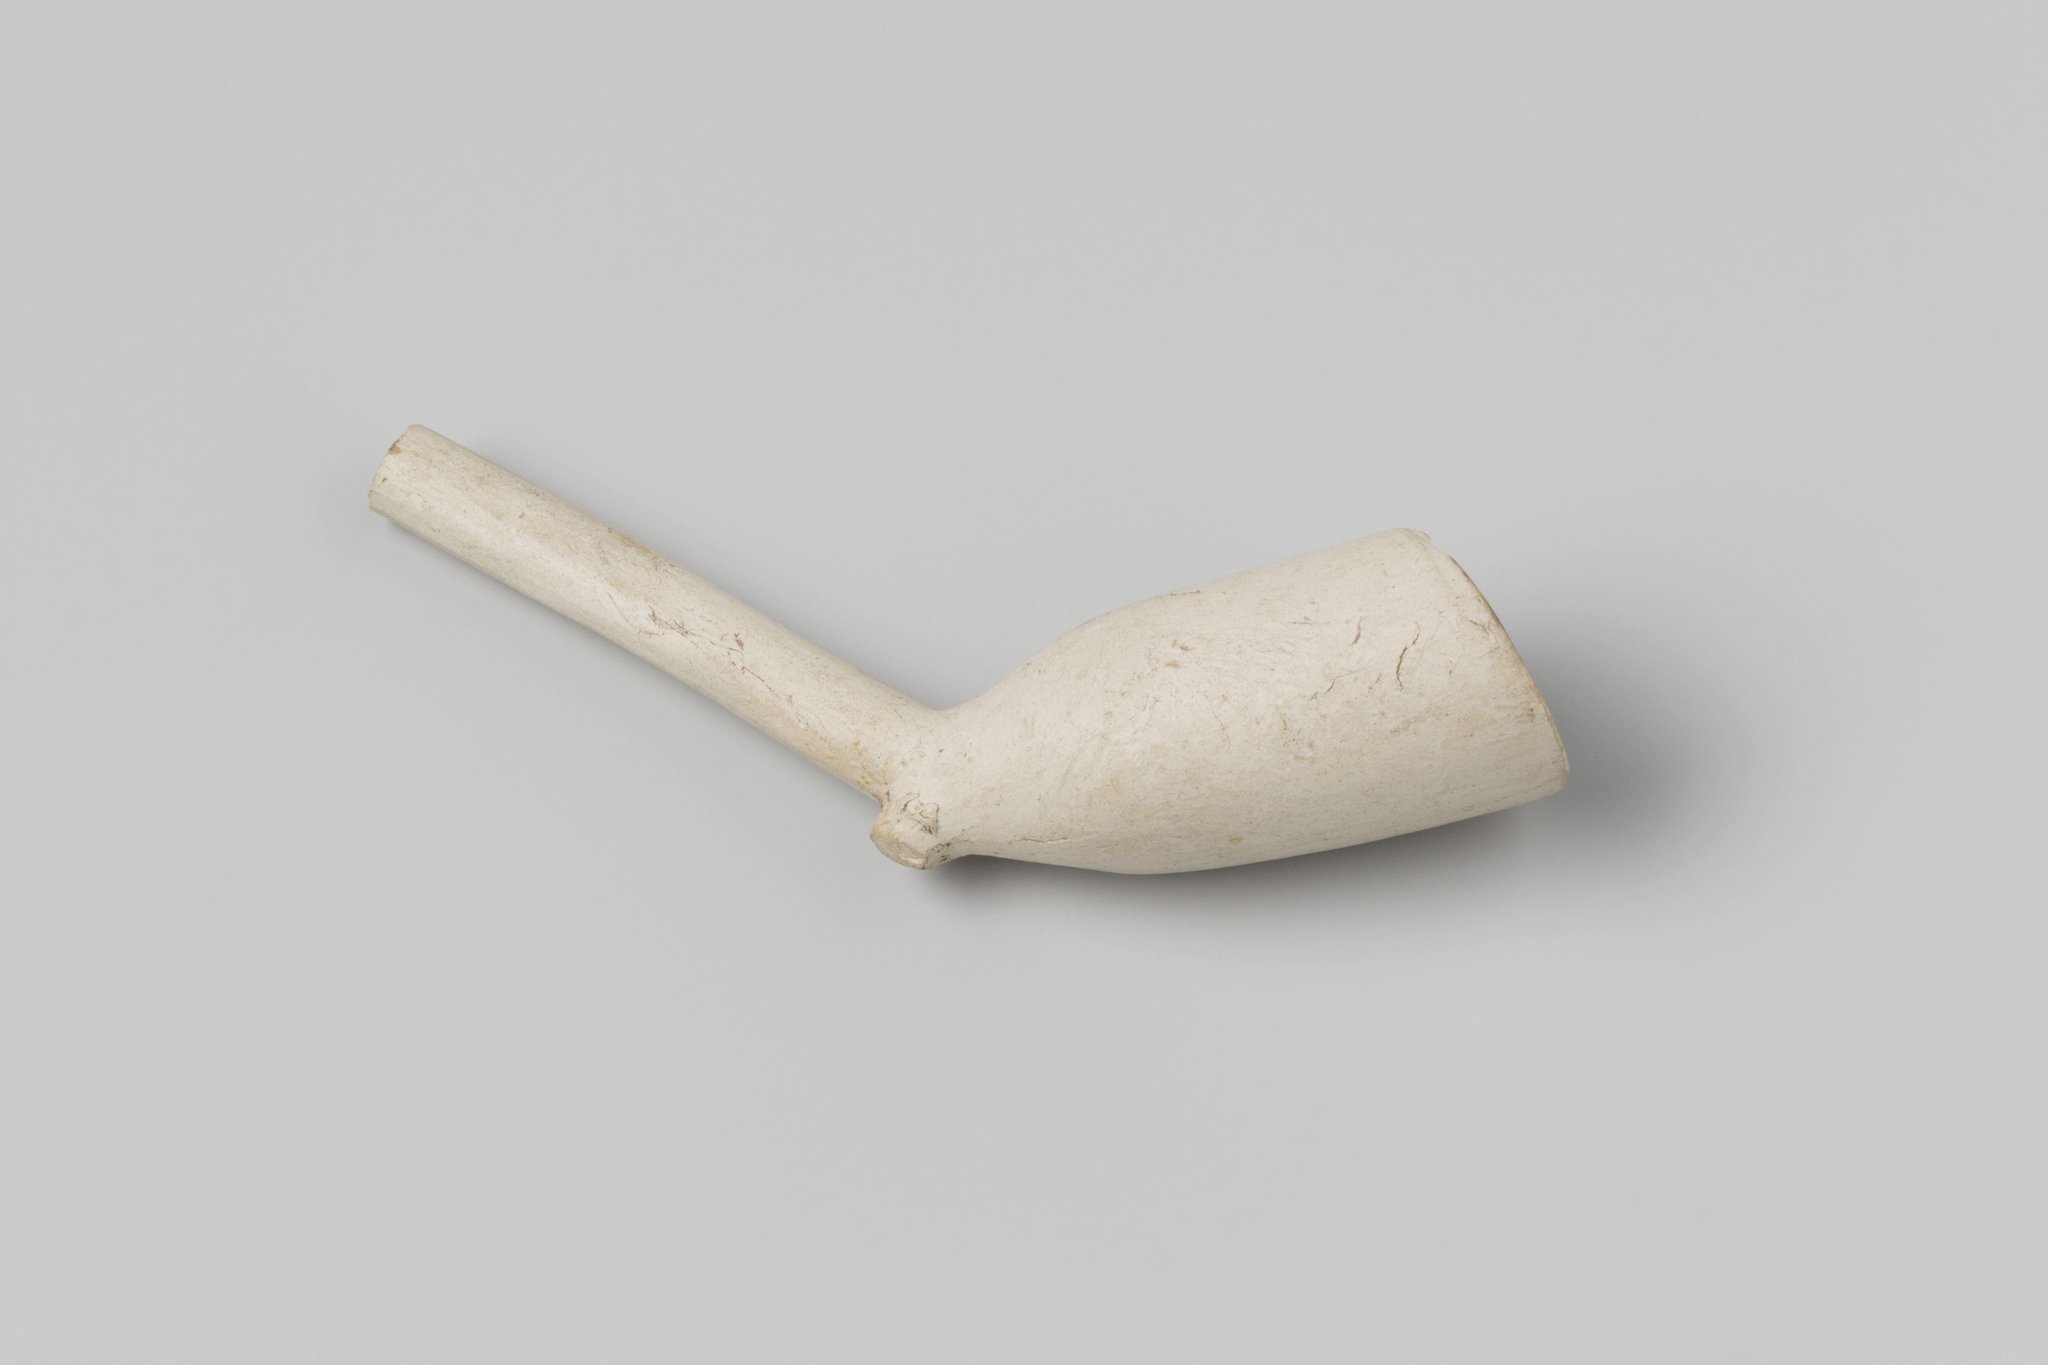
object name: pipe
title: Fragment van een tabakspijp.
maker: Anonymous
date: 1400-1950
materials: earthenware, clay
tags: loevestein castle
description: Fragment van een tabakspijp. Geheel glad.